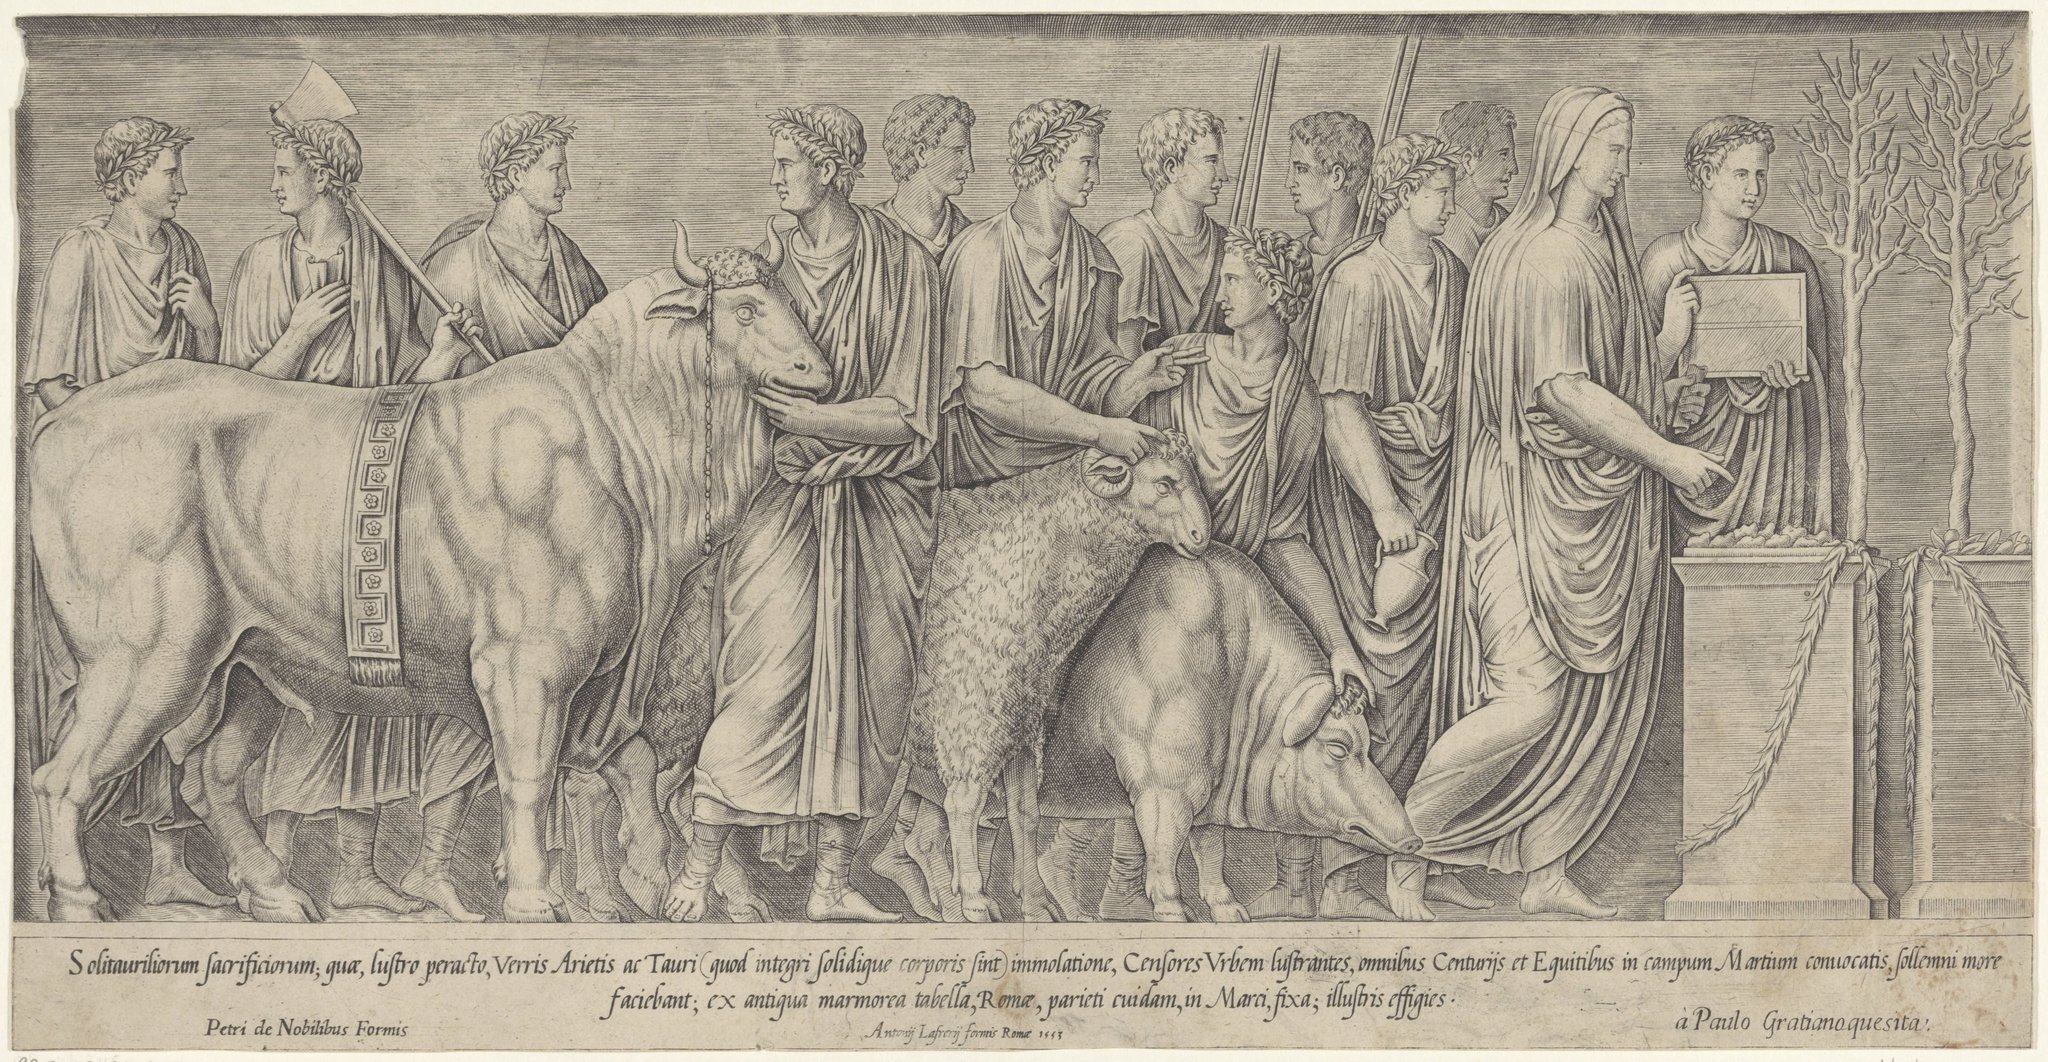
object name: print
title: Marmeren reliëf met een processie met offerdieren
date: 1553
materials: paper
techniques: engraving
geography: rome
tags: animal sacrifice ~ roman religion, piece of sculpture, reproduction of a piece of sculpture, procession ~ roman religion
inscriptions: collector's mark: Lugt 240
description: Naar een reliëf in de collectie van het Musée du Louvre te Parijs. Deze prent behoort tot het prentcorpus dat bekend staat als de ‘Speculum Romanae Magnificentiae’ (‘Spiegel van Romeinse pracht’). Dit corpus, bestaande uit prenten met voorstellingen van kunstwerken en gebouwen uit het antieke en het moderne Rome, vond zijn oorsprong bij uitgevers Antonio Salamanca en Antonio Lafreri. Deze twee buitenlandse uitgevers bundelden hun krachten te Rome in de periode 1553-1563. Hun prenten werden al snel razend populair bij toeristen en verzamelaars, die de prenten individueel of in grote groepen aanschaften. Grote groepen Speculum-prenten werden vaak op aanvraag samengebonden in albums. Er zijn verschillende Speculum-albums overgeleverd die allemaal verschillen van inhoud. Tussen 1573 en 1577 gaf Antonio Lafreri een speciale titelpagina uit (met de titel ‘Speculum Romanae Magnificentiae’) die mensen voor hun verzamelingen konden voegen. Het overlijden van Lafreri in 1577 betekende niet het einde van het corpus. Een groot deel van de koperplaten ging over op Claudio en Stefano Duchetti. De rest raakte verspreid over verschillende andere uitgevers. De populariteit van de Speculum-prenten wist nog geruime periode uitgevers te inspireren tot het laten maken van kopieën en het toevoegen van nieuwe prenten aan het corpus.